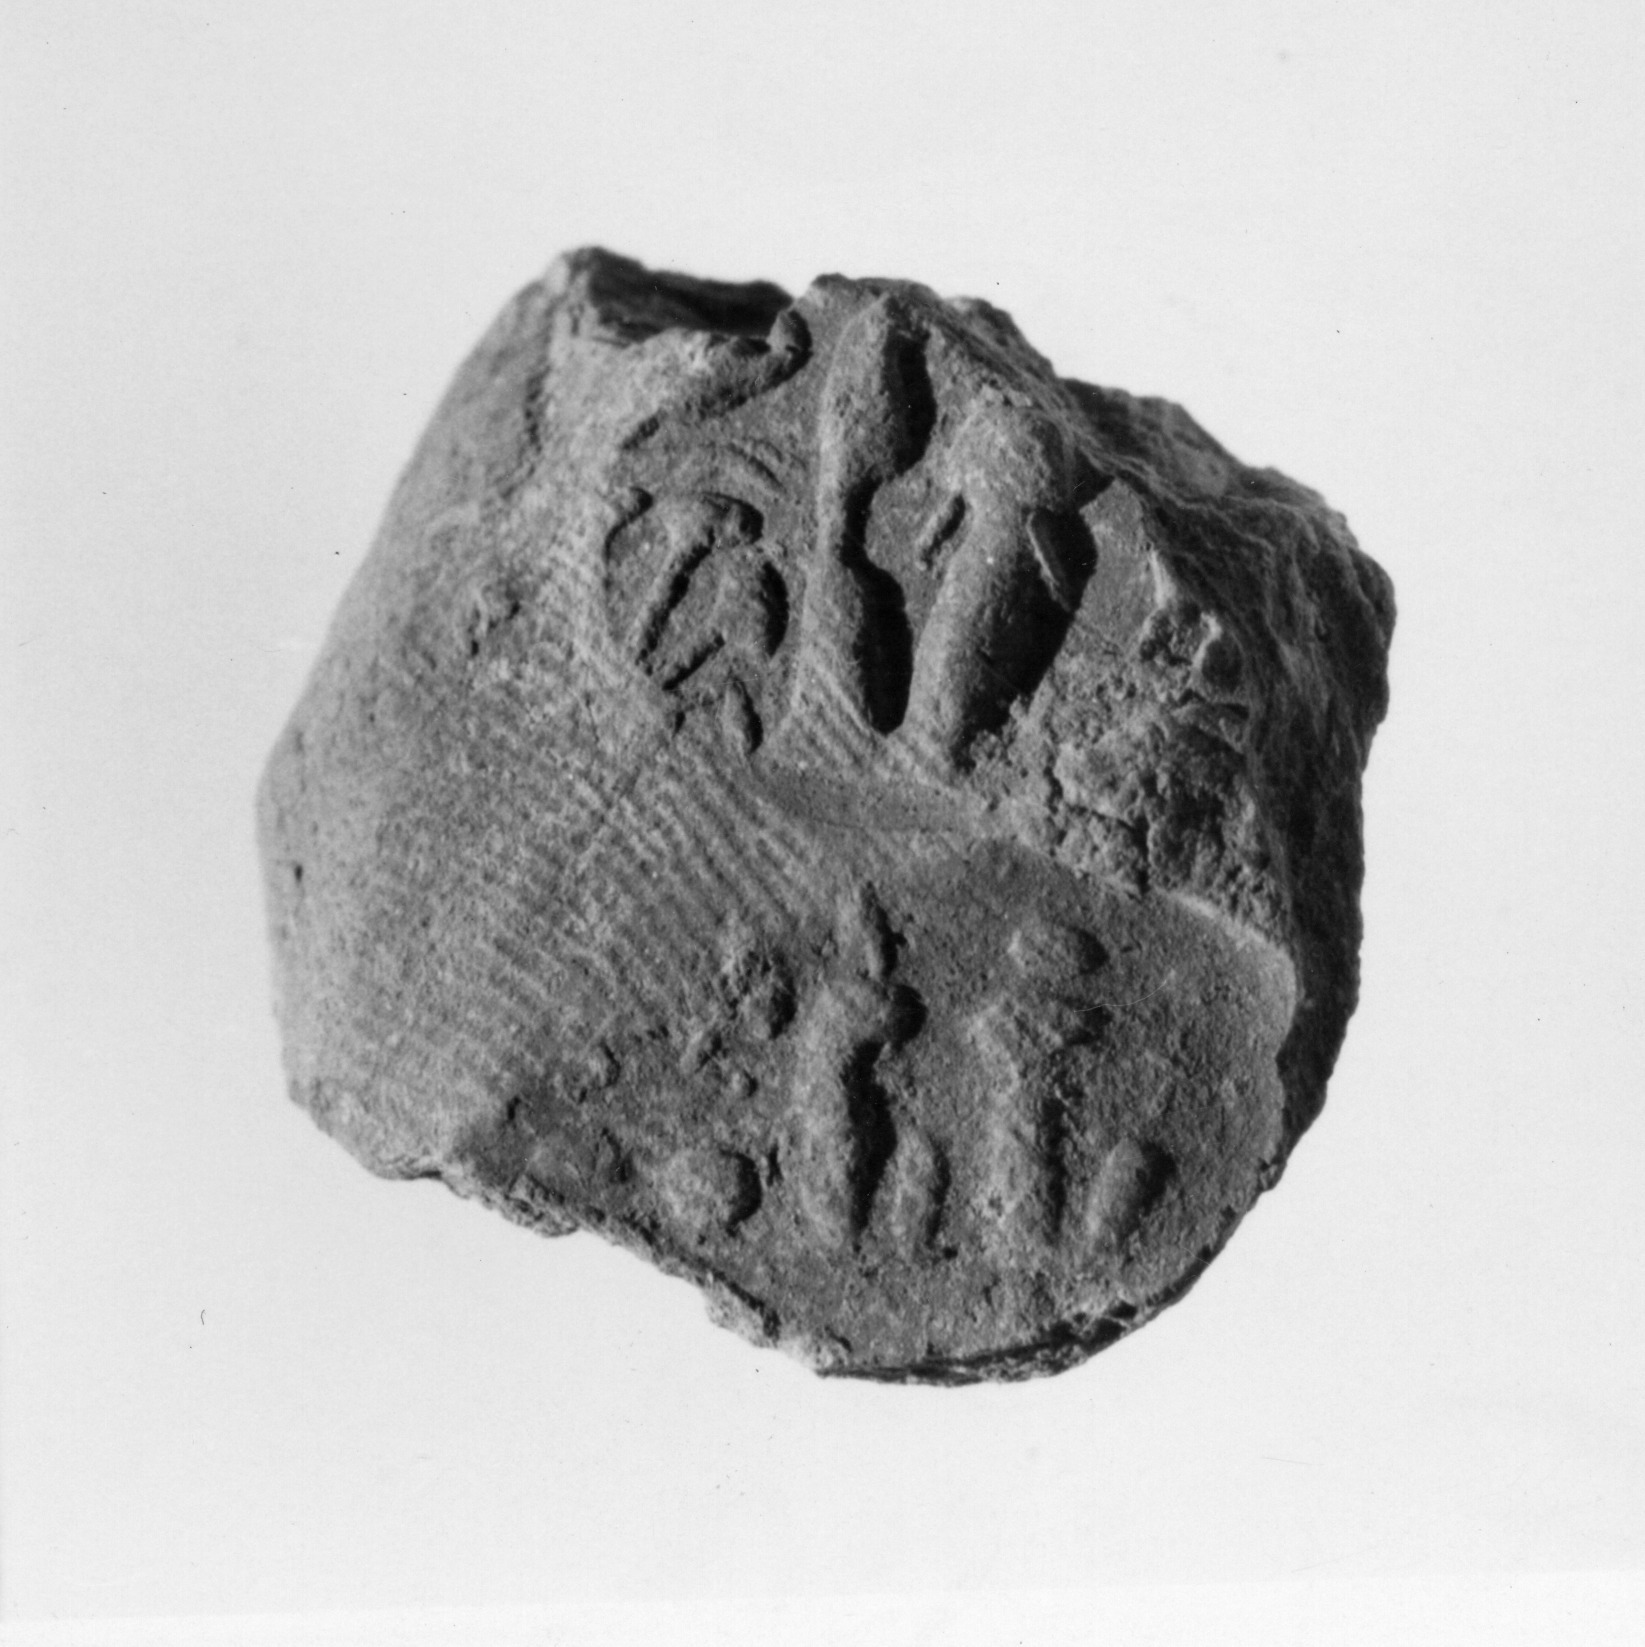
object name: sealing, nebmaatre, amenhotep iii,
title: Document Sealing With Multiple Seal Impressions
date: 1390-1352 BCE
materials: mud